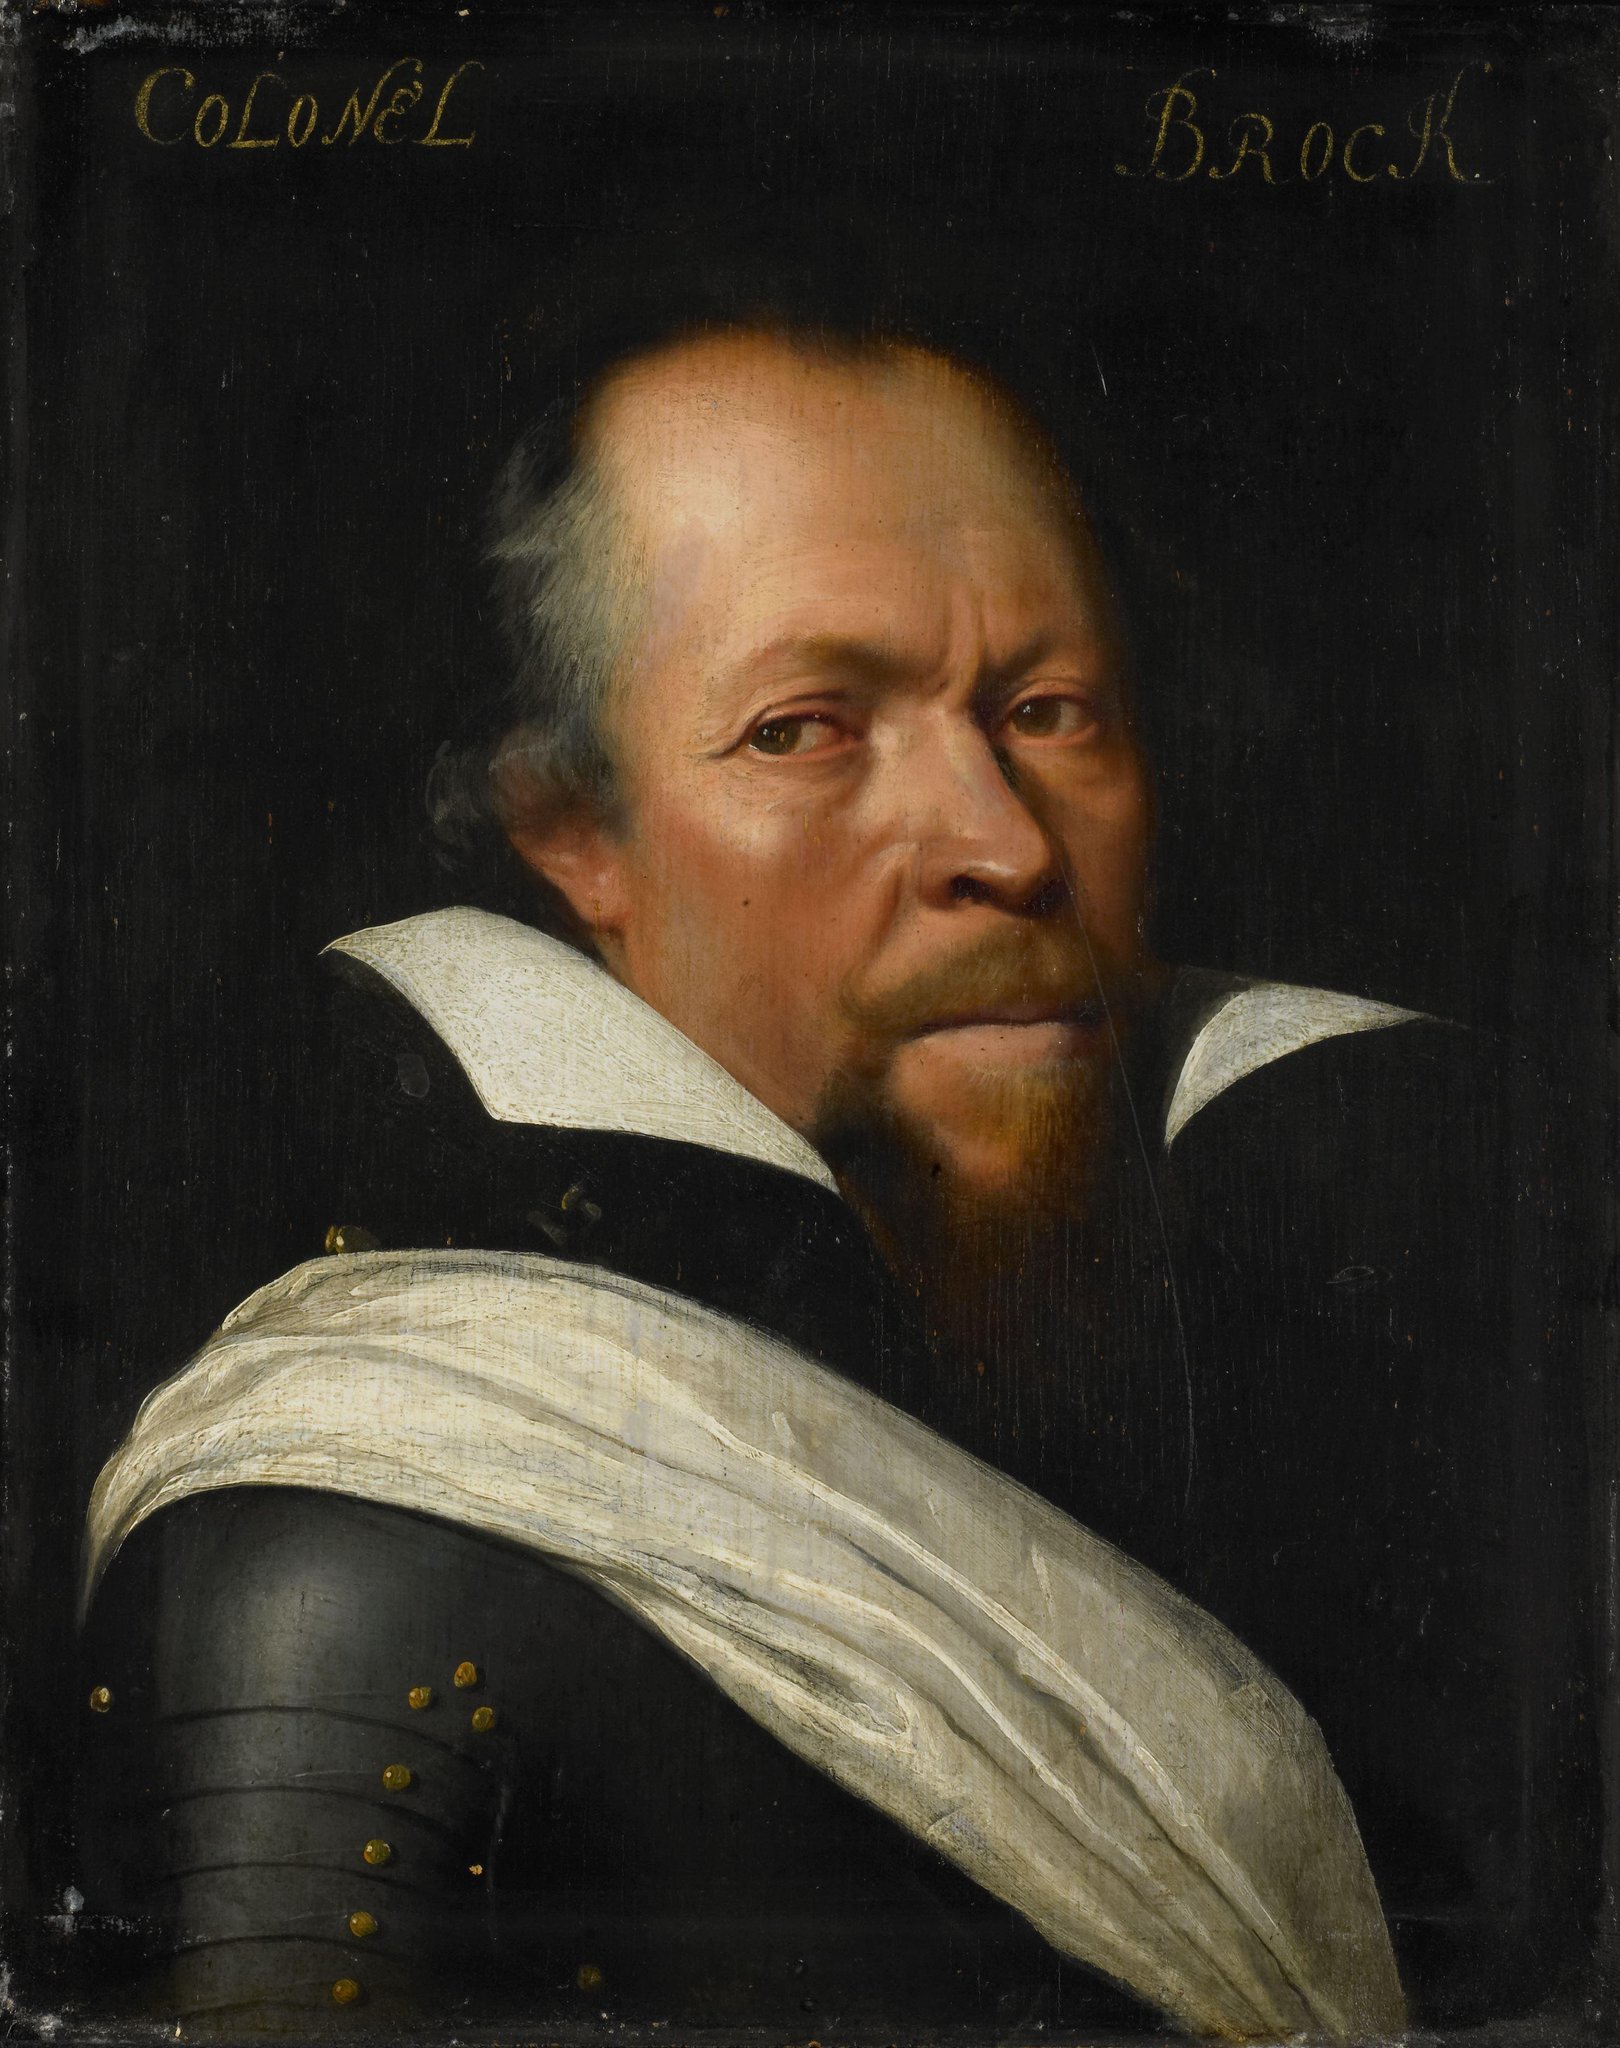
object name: painting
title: Portrait of Sir William Brog (1563-1636)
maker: jan antonisz van ravesteyn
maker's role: draughtsman, painter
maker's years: 1570-1657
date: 1609-1633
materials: oil, panel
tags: historical persons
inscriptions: inscription, top: ‘Colonel Brock’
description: Sir William Brog (?-1636), naar J.A. van Ravesteyn.